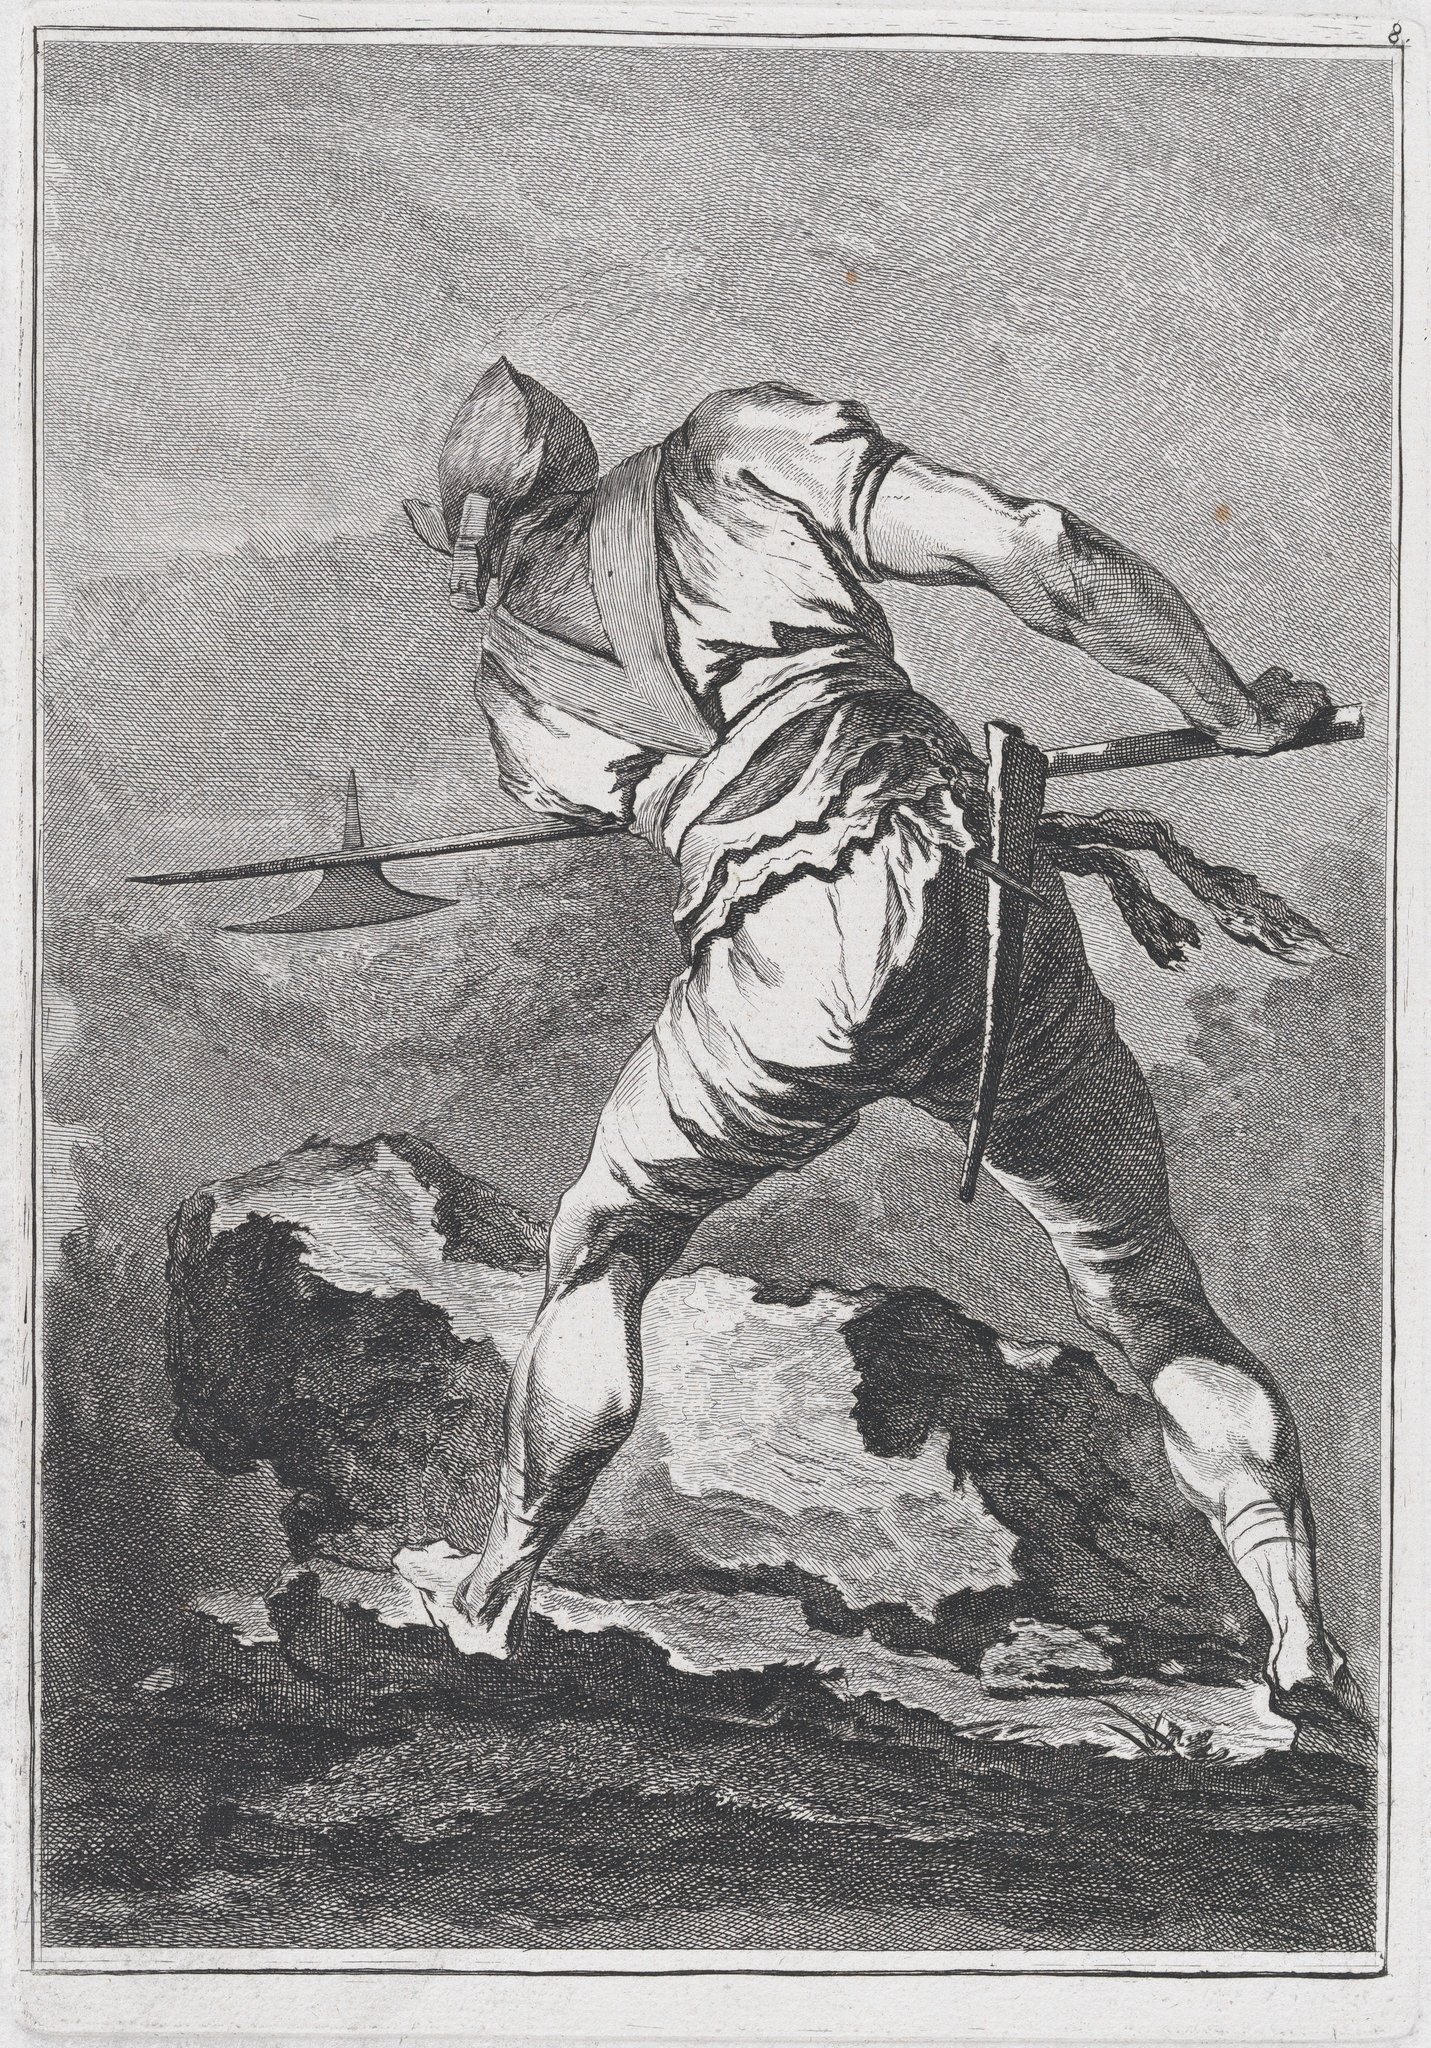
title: Lunging Soldier Seen from Behind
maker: matthias pfenninger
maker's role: etcher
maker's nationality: swiss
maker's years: 1739-1813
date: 1764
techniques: etching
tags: soldiers,weapons,men